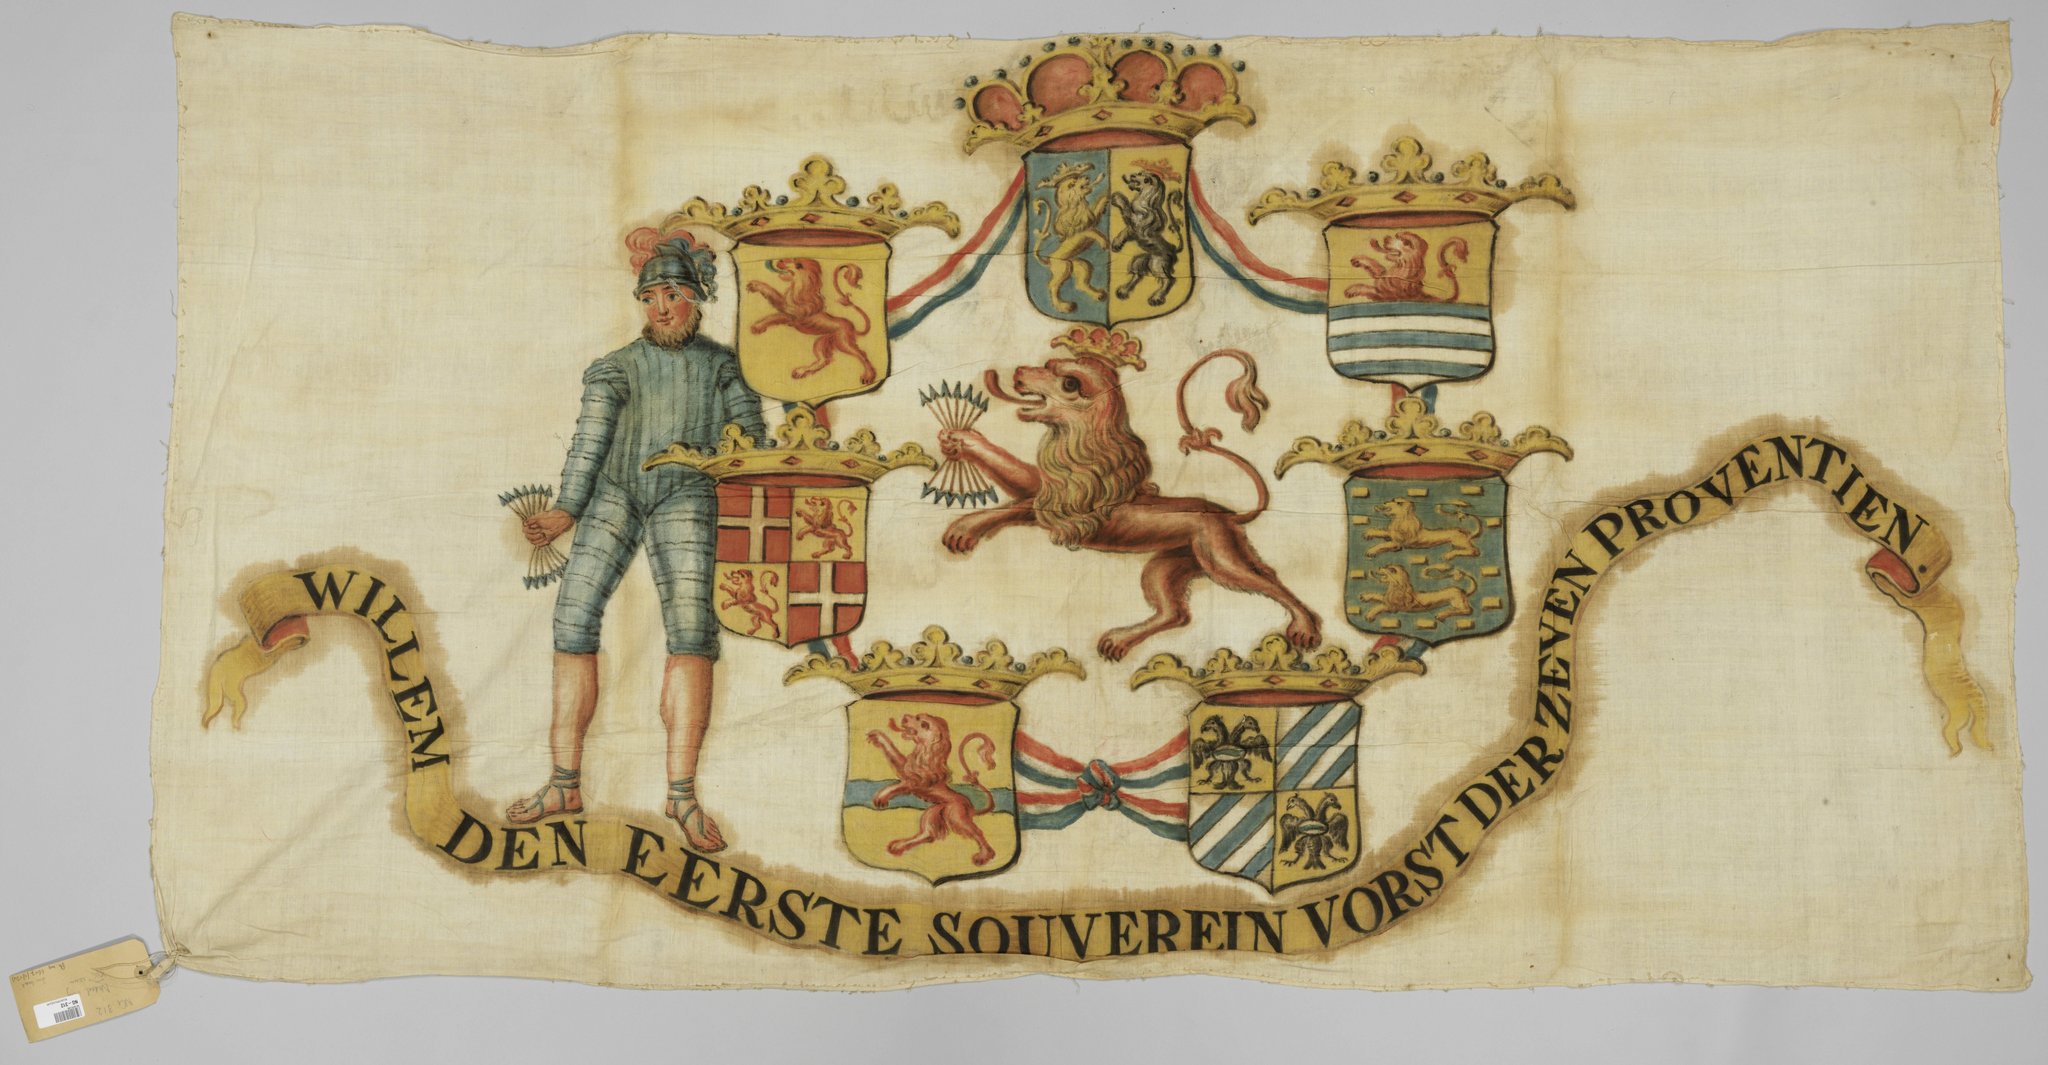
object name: flag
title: Fragment van de Nederlandse vlag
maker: Anonymous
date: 1840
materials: cotton, paint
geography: netherlands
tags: the hague, william i of the netherlands, netherlands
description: Middendeel van een vlag; op wit een rode gekroonde klimmende leeuw, met in de rechterklauw zeven pijlen (met punten aan beide zijden), omringd door de gekroonde, door een rood-wit-blauw lint verbonden wapens der zeven provinci%n, in protocolaire volgorde: Gelderland, Holland, Zeeland, Utrecht, Friesland, Overijssel, Groningen. Links een geharnaste man met zeven pijlen in de rechterhand. Onderaan een gele, rood gevoerde banderol, waarop in zwarte kapitalen: WILLEM DEN EERSTE SOUVEREIN VORST DER ZEVEN PROVINTIEN.